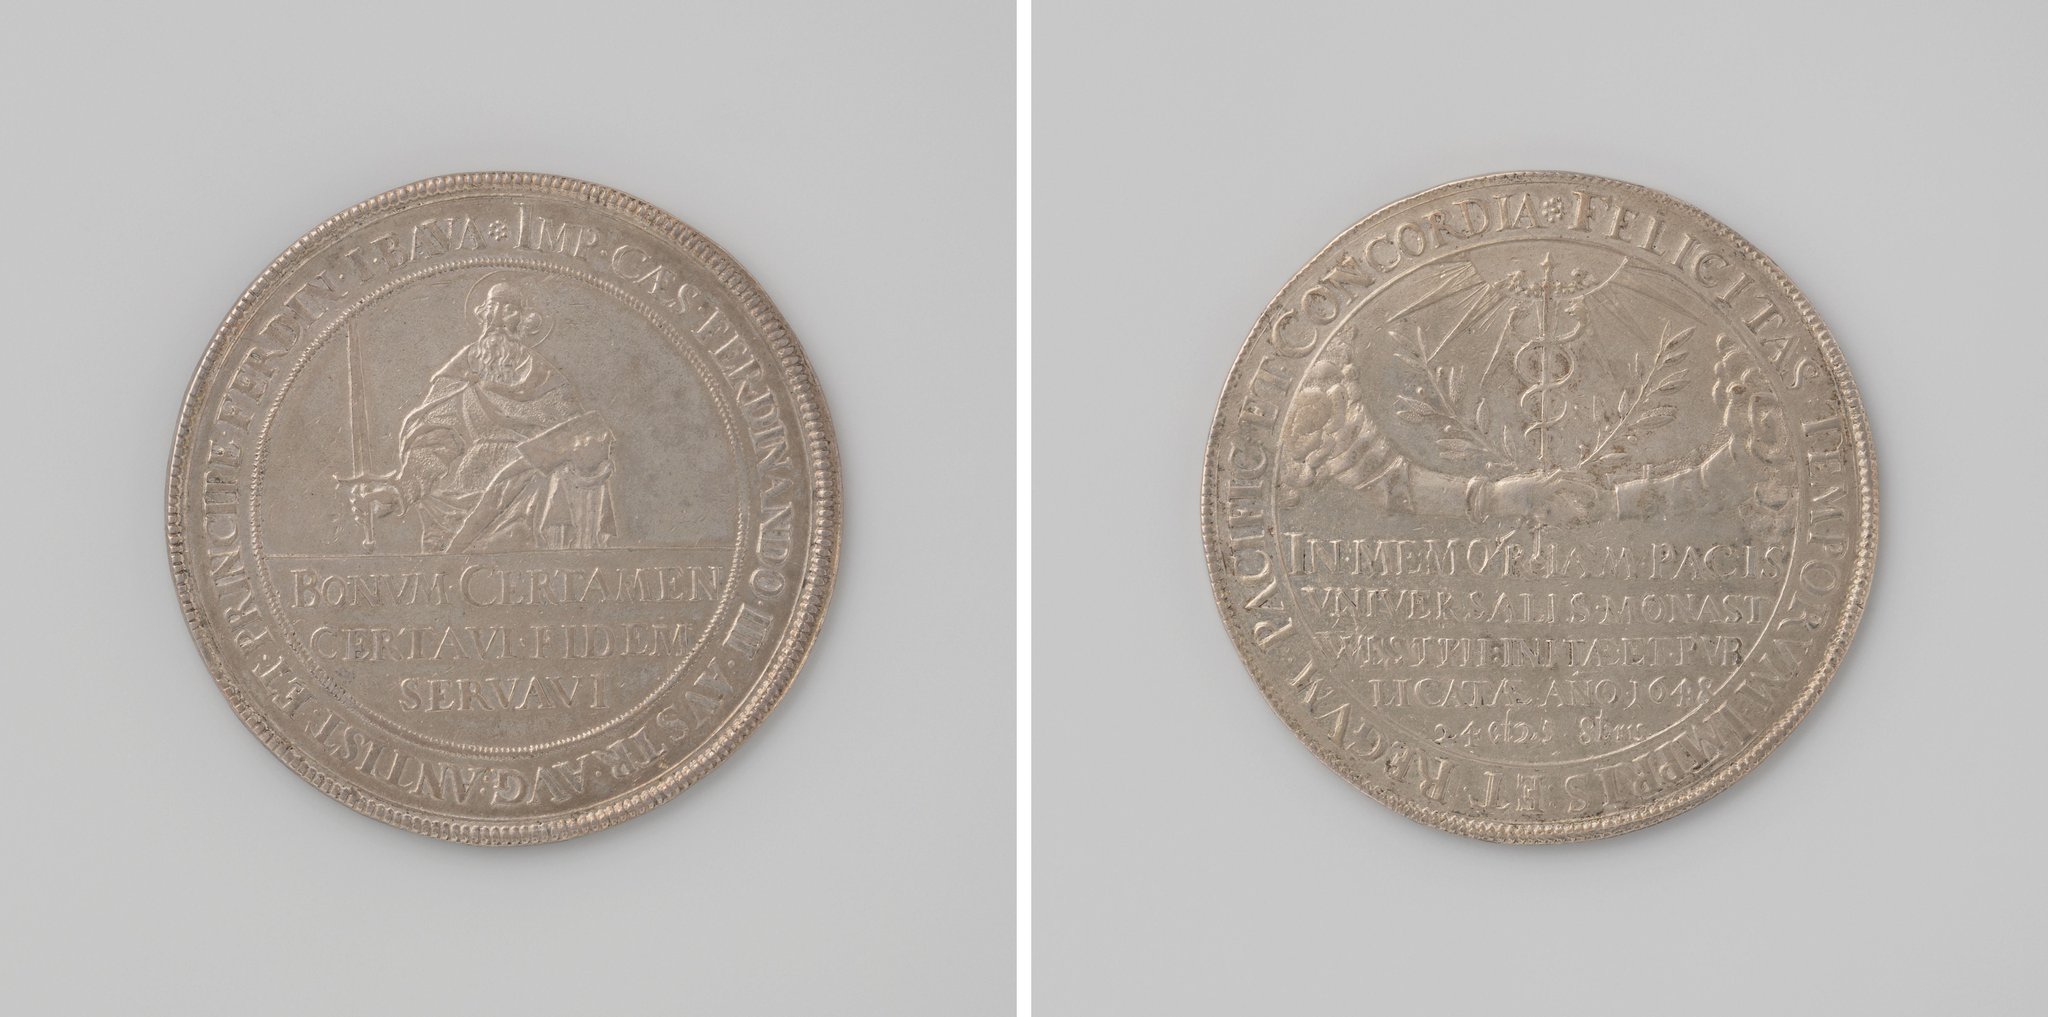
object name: medal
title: Penning over de Vrede van Munster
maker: Anonymous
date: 1648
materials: silver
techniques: striking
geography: germany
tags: münster, noordrijn-westfalen, vrede van münster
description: Zilveren penning. Voorzijde: beeltenis van de apostel Paulus met zwaard en bijbel, boven opschrift binnen omschrift. Keerzijde: twee handen met vredesstaf en olijftakken boven opschrift binnen omschrift.